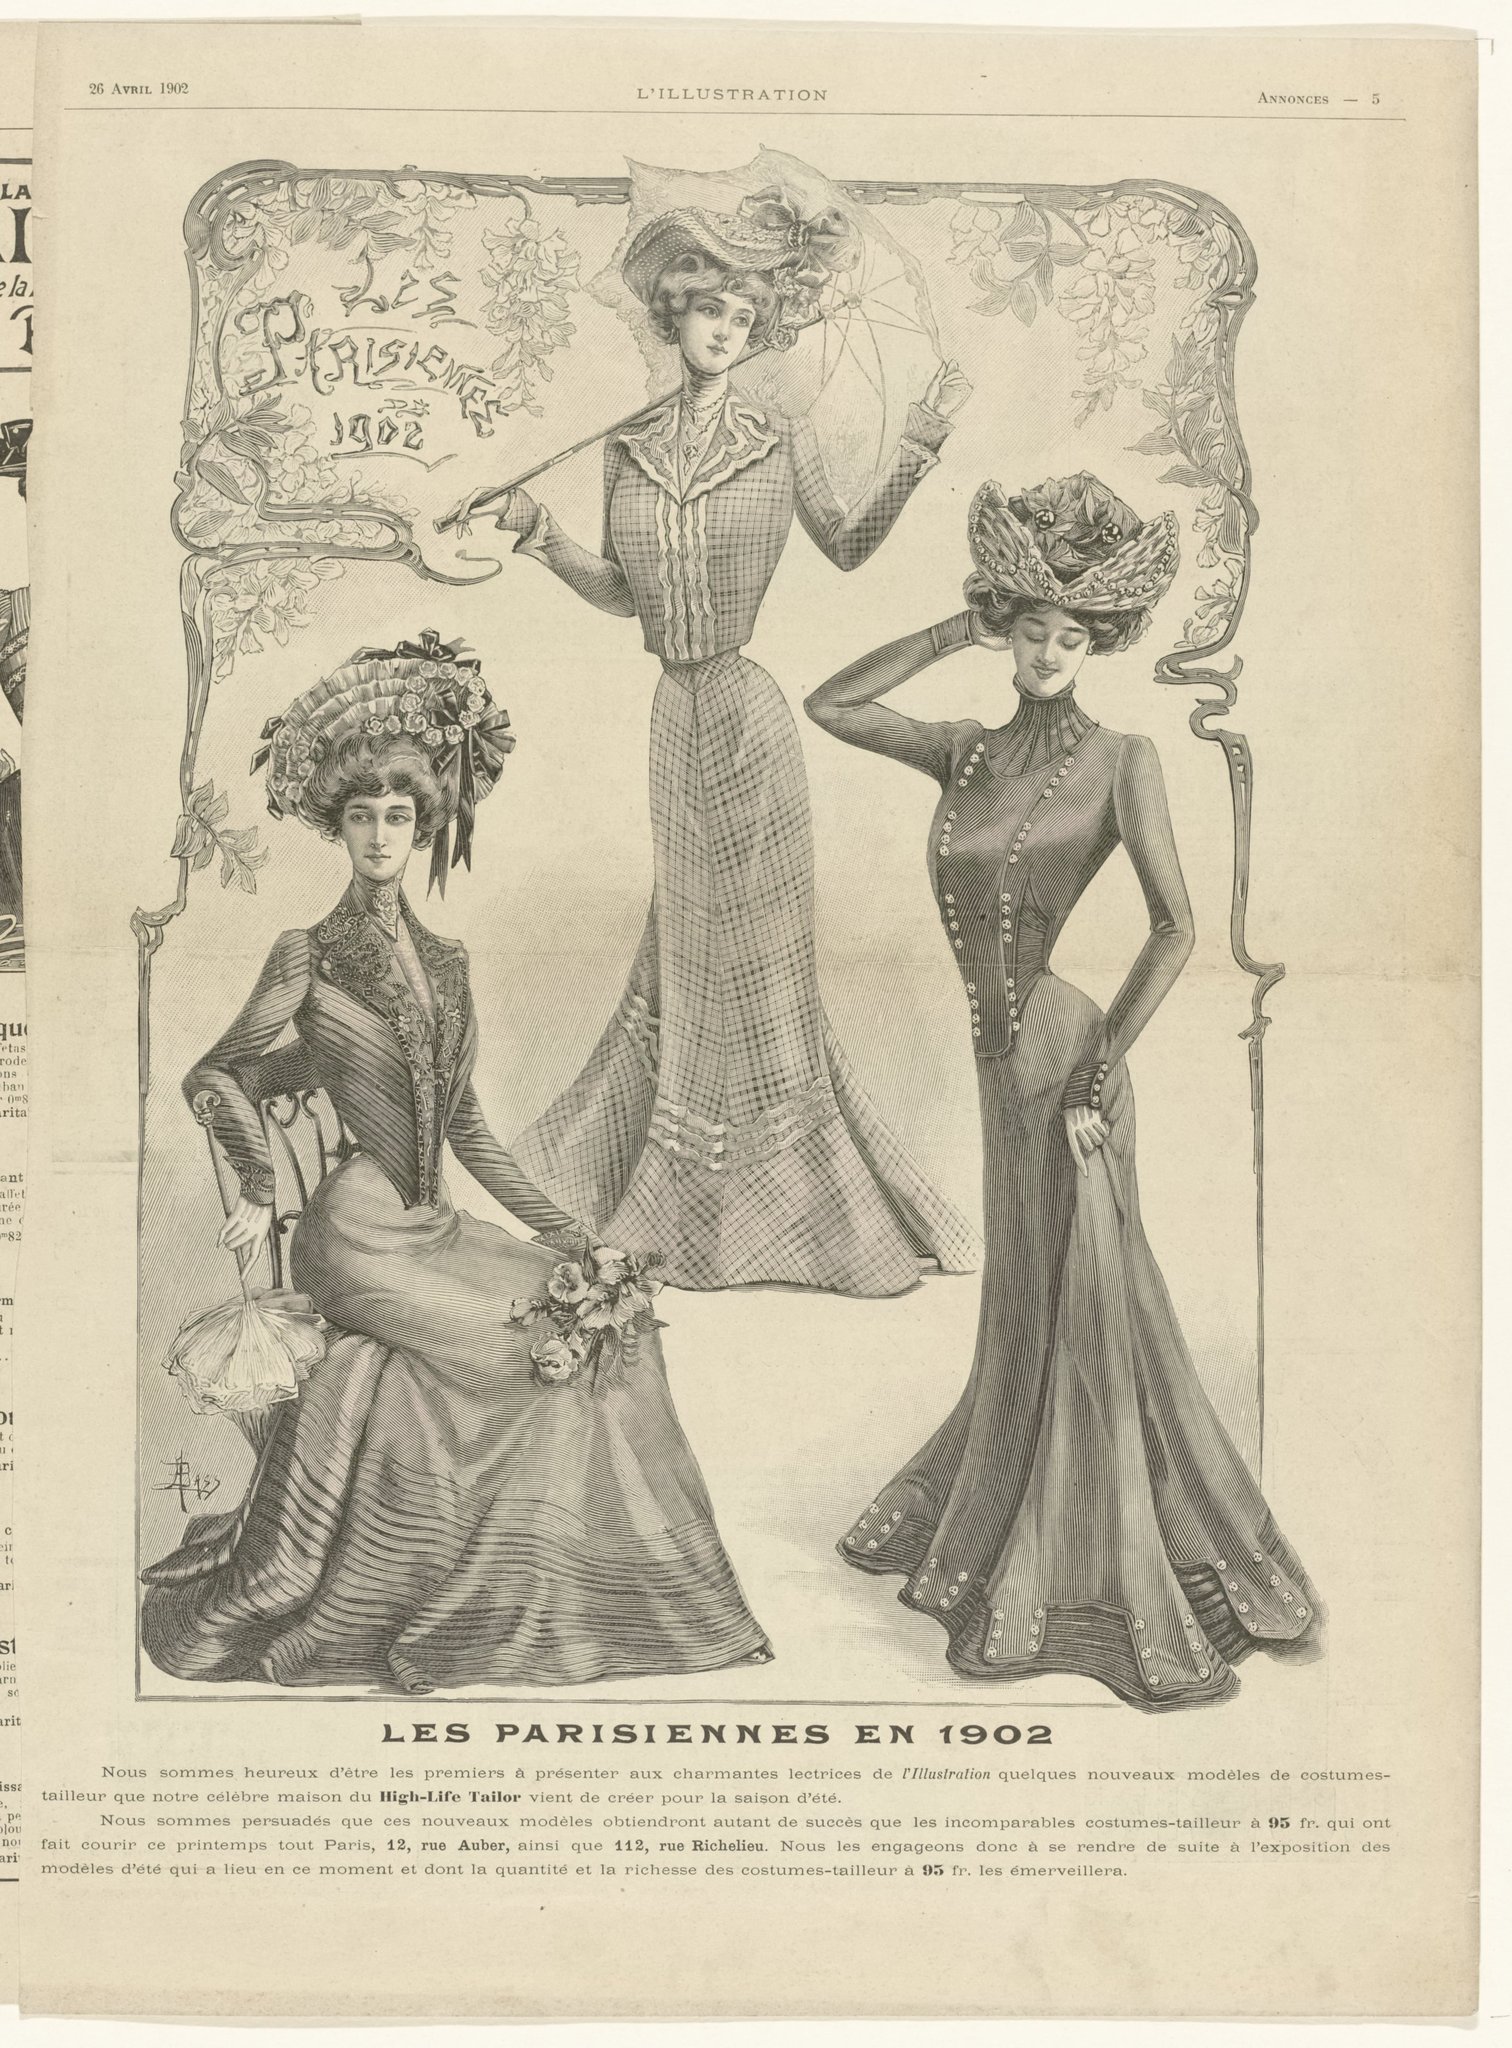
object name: fashion print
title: L'illustration, 26 avril 1902, annonces, p. 5: Les Parisiennes en 1902 (...)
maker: Anonymous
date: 1902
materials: paper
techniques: engraving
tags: cut flowers; nosegay, bunch of flowers, ensembles of pieces of clothing (suit) (+ women's clothes), fashion plates, head-gear: hat (+ women's clothes), parasol, sunshade (+ women's clothes)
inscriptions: caption: ‘Nous sommes heureux d'être les premiers à présenter aux charmantes lectrices de l'Illustration quelques nouveaux modèles de costumes-tailleur que notre célèbre maison du High - Life Tailor vient de créer pour la saison s'été. Nous sommes persuadés que ces nouveaux modèles obtiendront autant de succès que les incomparables costumes-tailleur à 95 fr. qui ont modèles d'été qui a lieu en ce moment et dont la quantité et la richesse des costumes-tailleur à 95 fr. les émerveillera.’, inscription: ‘Les Parisiennes 1902’, title: ‘LES PARISIENNES EN 1902’, title: ‘L'ILLUSTRATION’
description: Drie mantelpakken voor de zomer van 'High-Life Tailor'. Verso p. 6 : diverse advertenties.